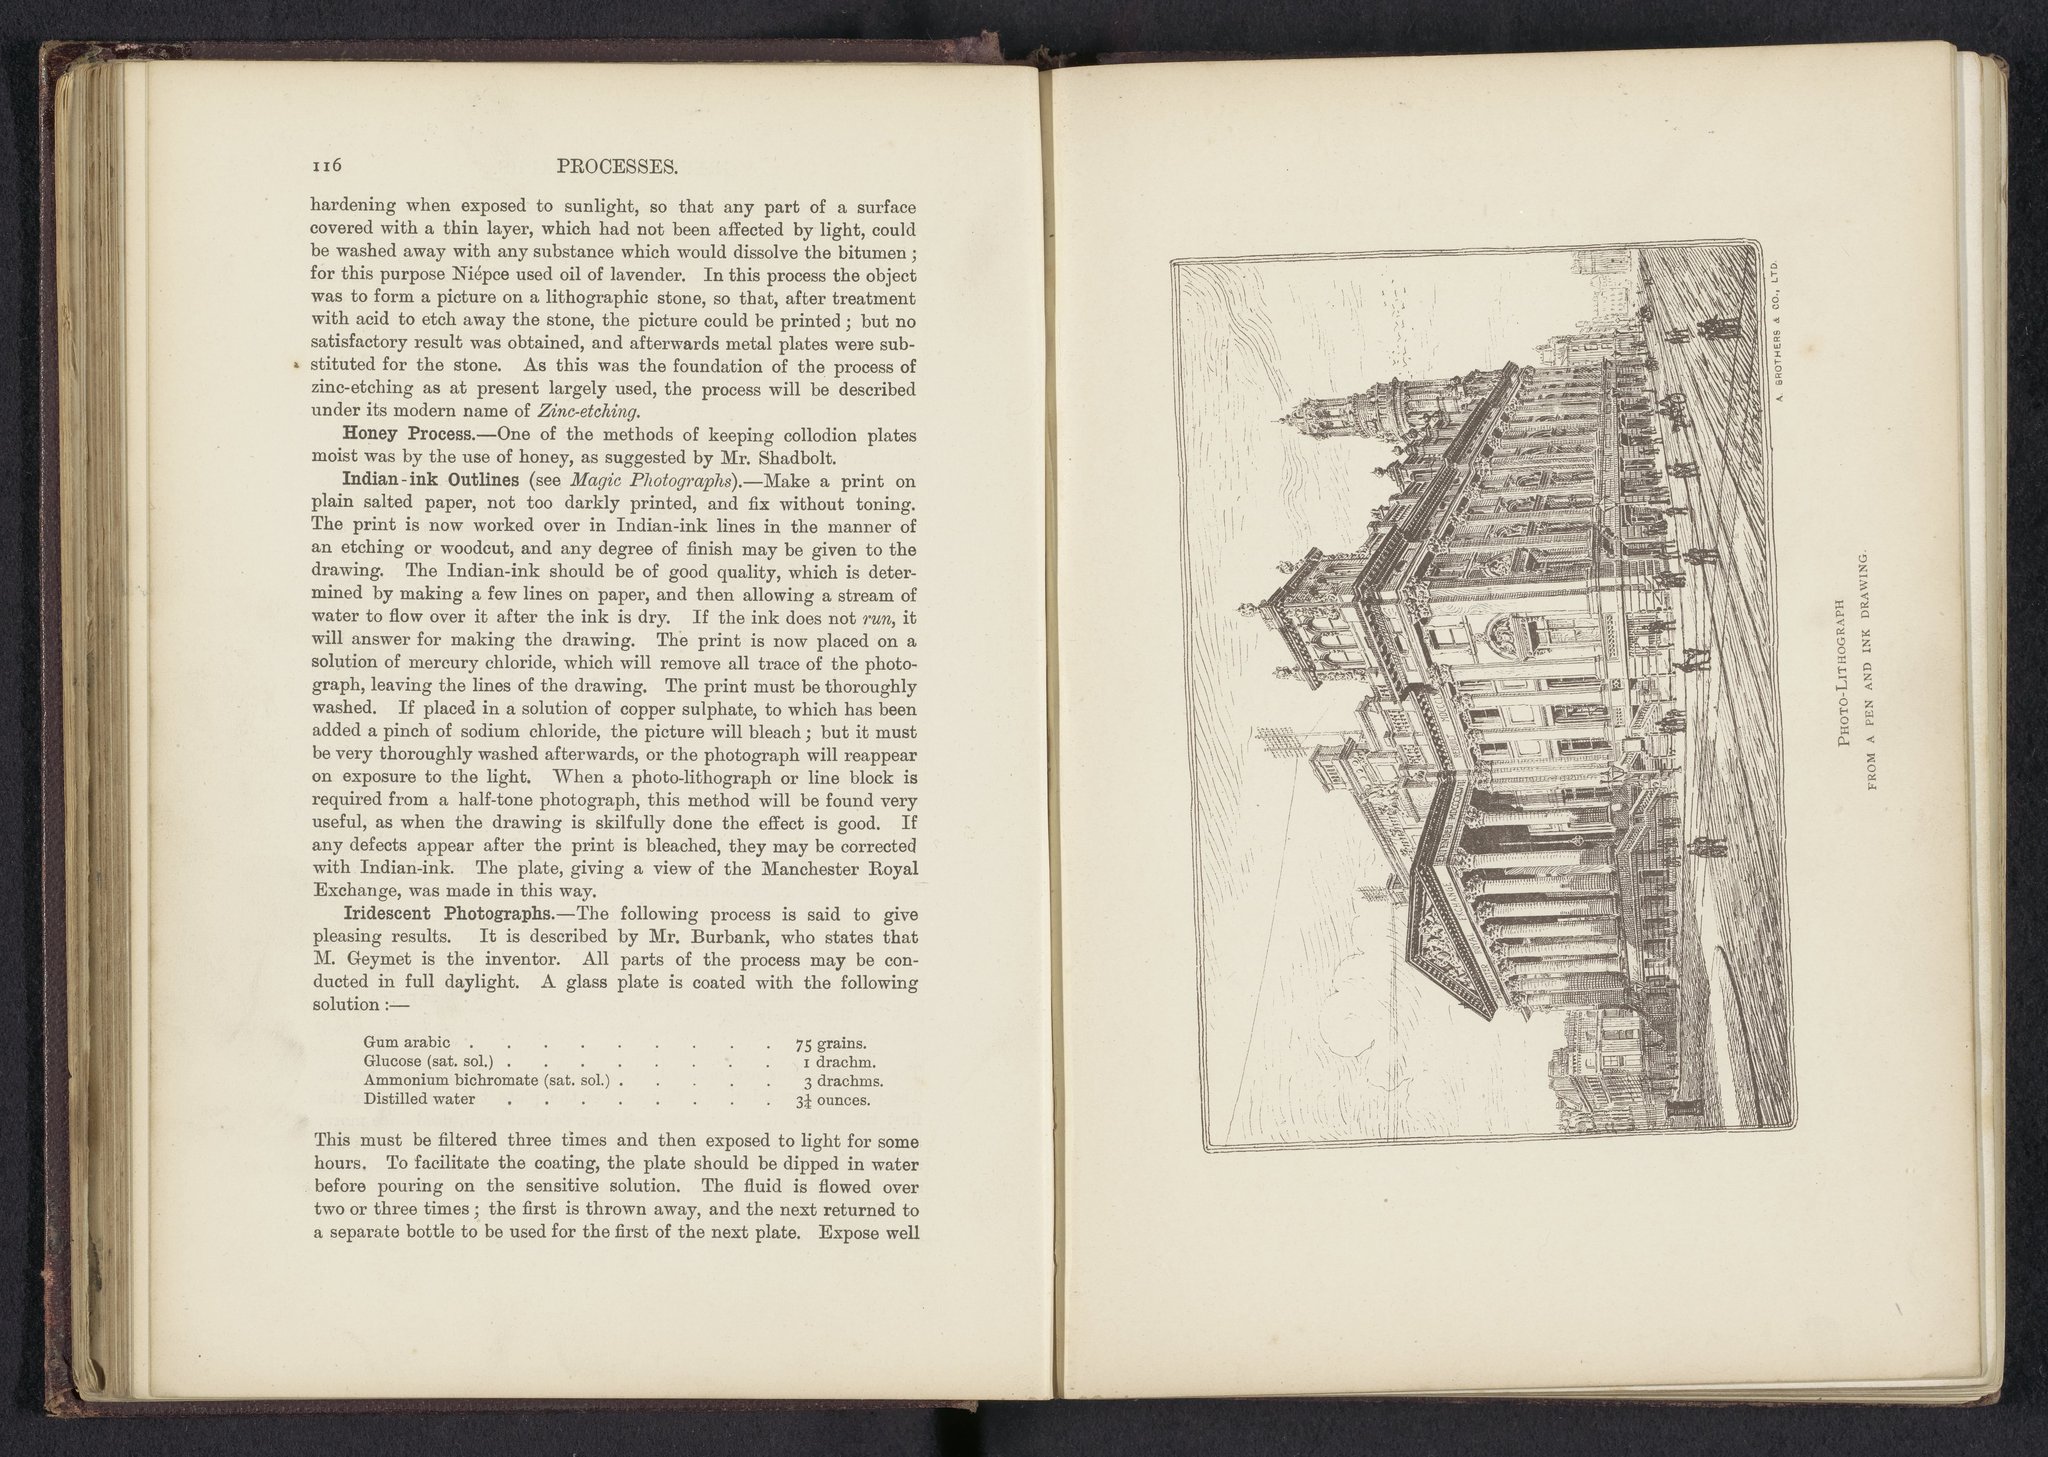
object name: photomechanical print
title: A check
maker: Anonymous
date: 1889-1899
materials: paper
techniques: photolithography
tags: stock exchange, stock-market, façade (of house or building)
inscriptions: inscription: ‘Photo-lithograph from a pen and ink drawing’